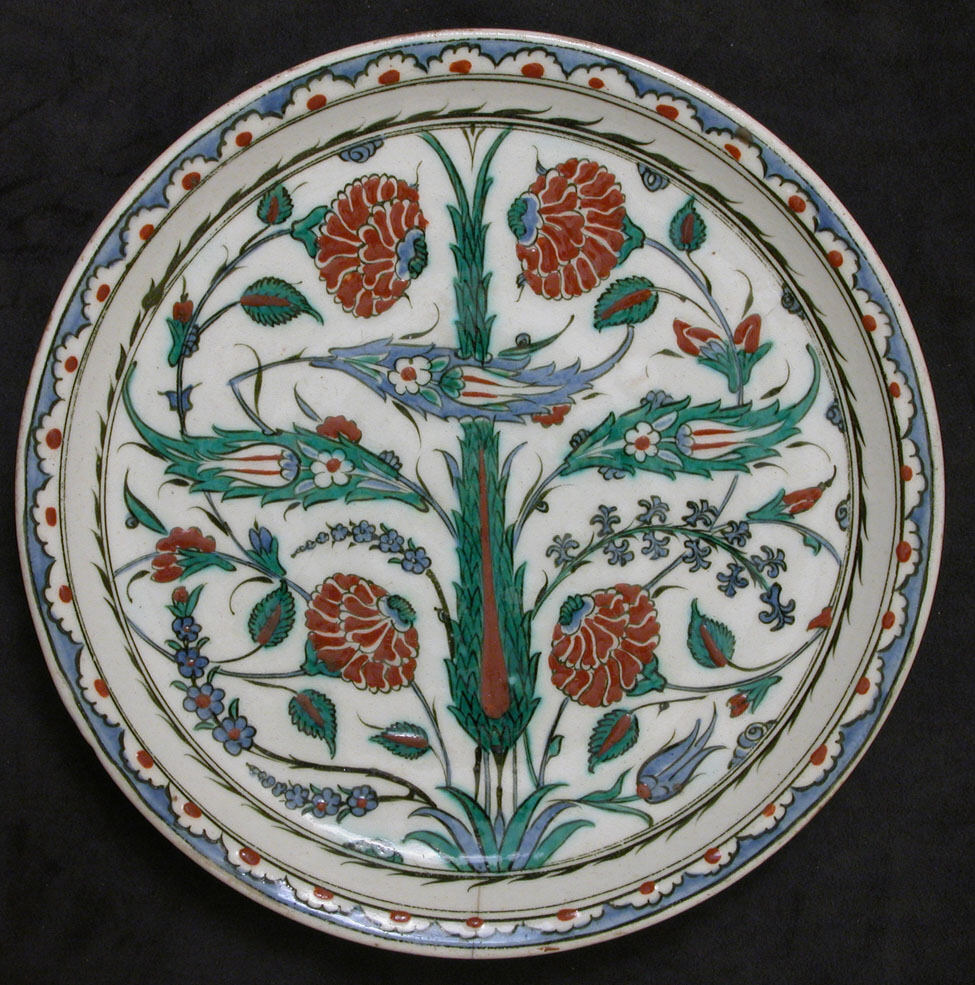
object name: dish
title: Dish with Cypress Tree, Saz Leaves, and Roses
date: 1575-1580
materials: glaze, stonepaste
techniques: painting, polychrome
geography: turkey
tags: flowers,leaves